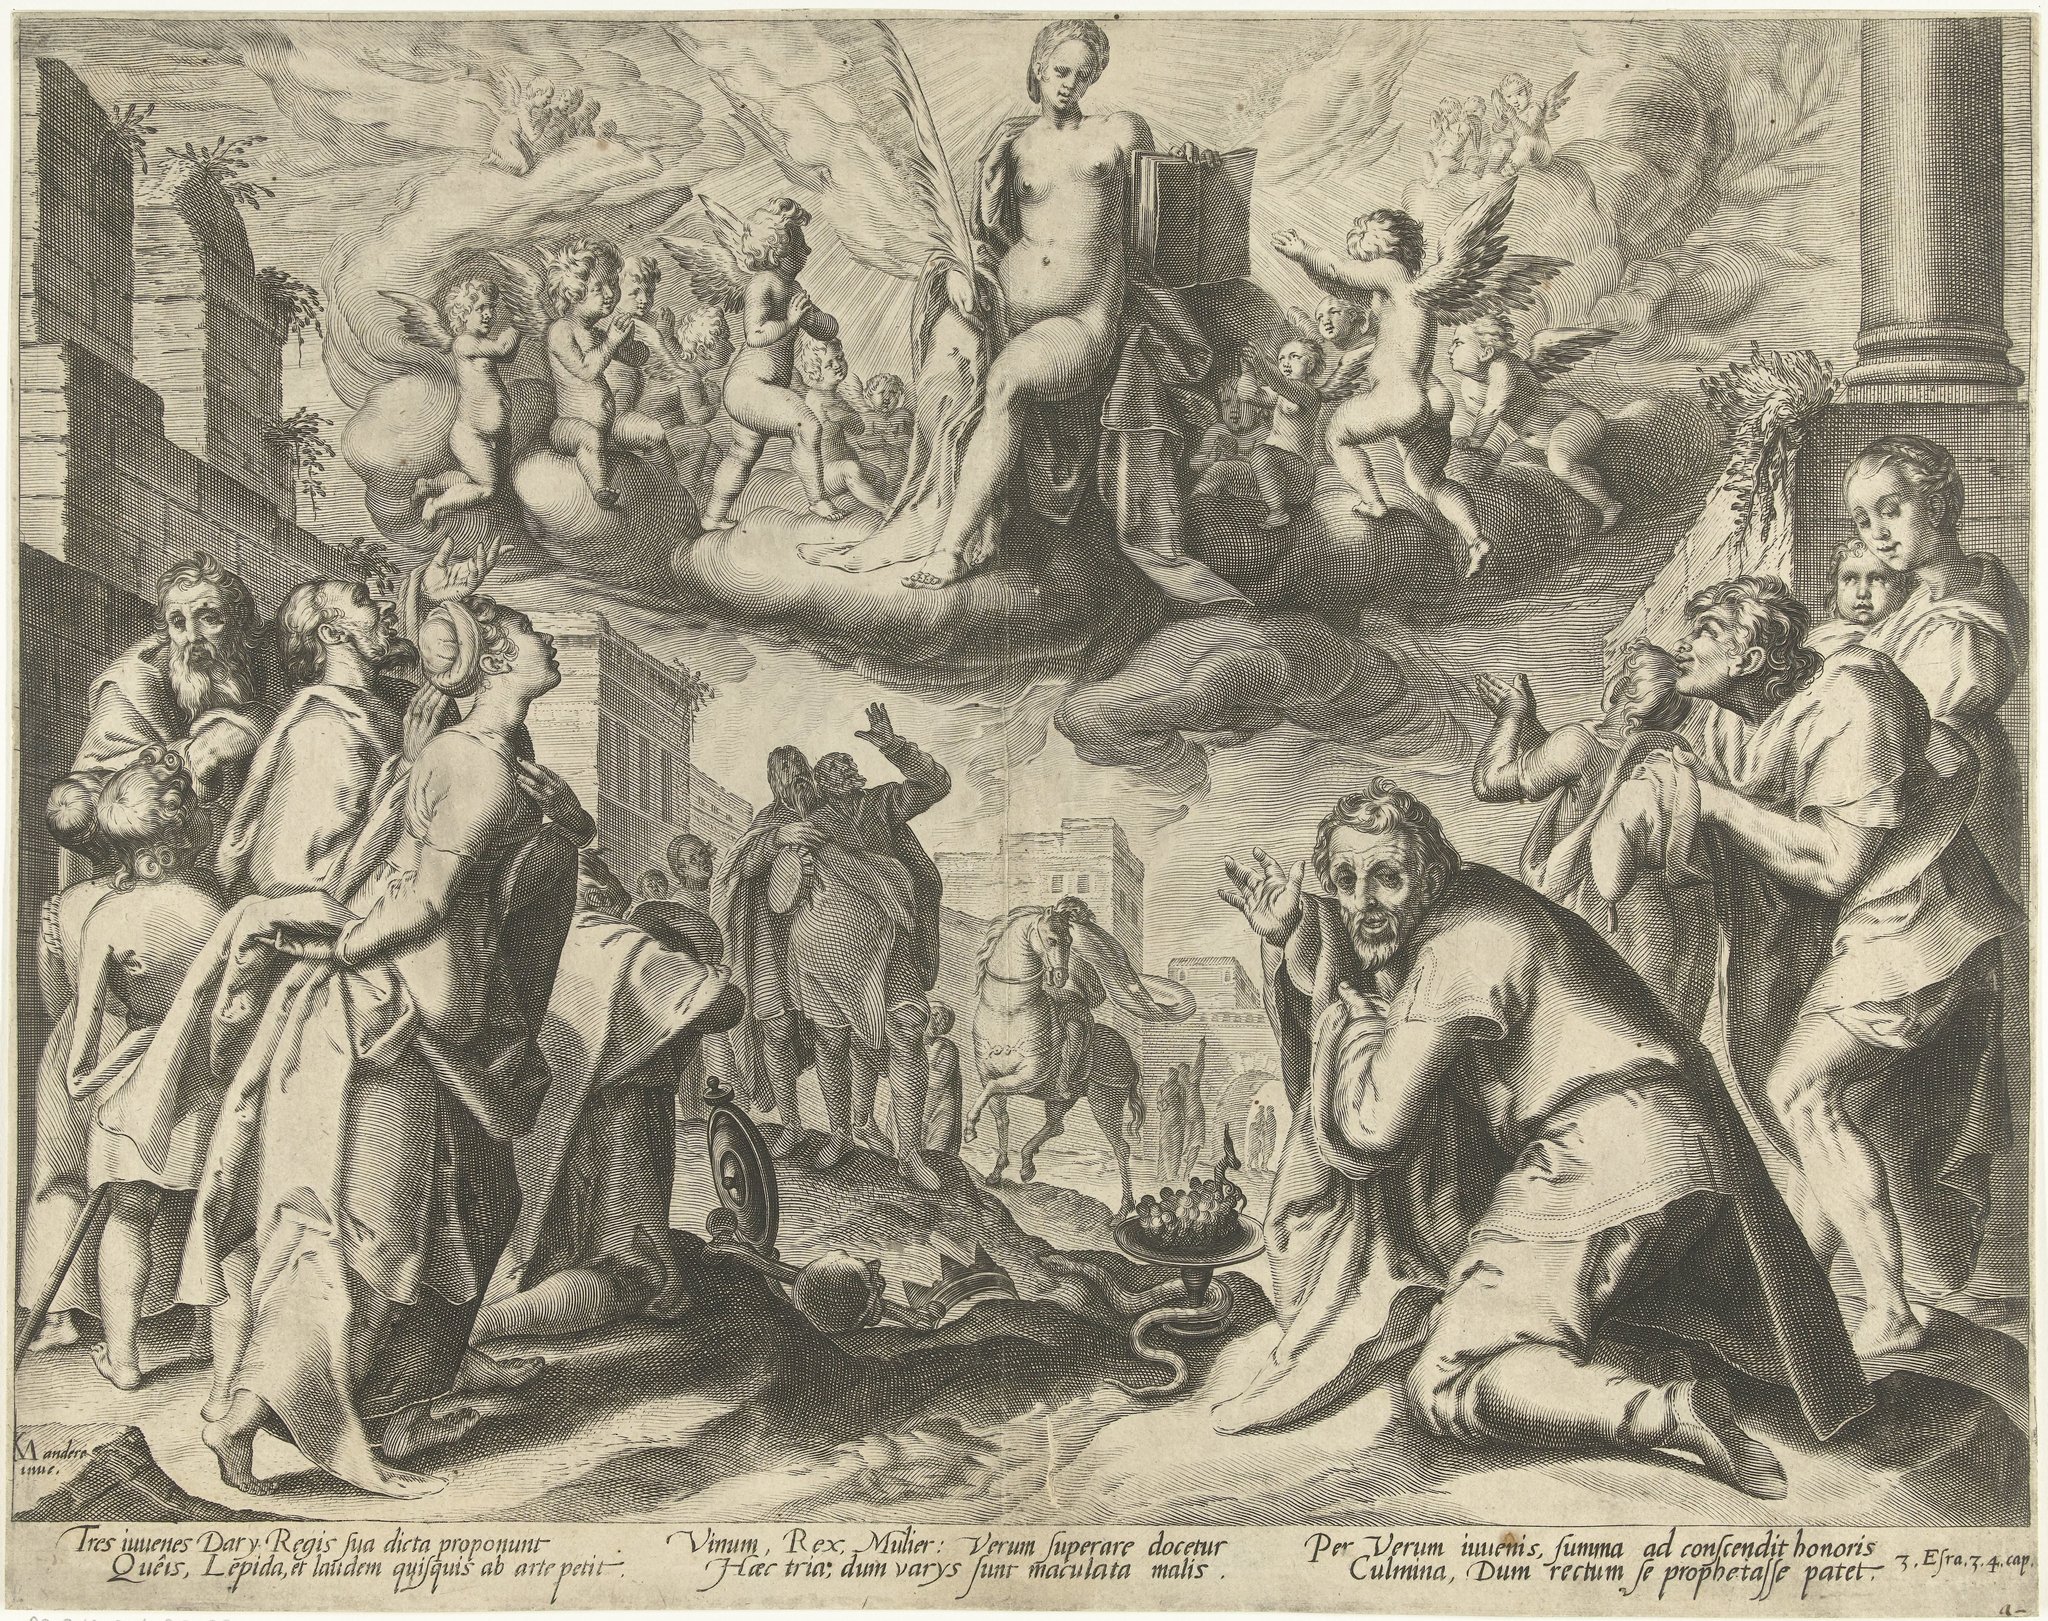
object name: print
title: Triomf van de waarheid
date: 1558-1606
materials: paper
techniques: engraving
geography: amsterdam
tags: the contest of the three guardsmen in king darius' bedchamber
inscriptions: collector's mark: Lugt 2228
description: Een straat in een stad. Mensen staan of knielen voor de vrouwelijke verschijning van De Waarheid, die boven hun hoofden zweeft. Ze draagt een palmtak in haar rechterhand en een boek in haar linkerhand. Een engelenkoor knielt rondom haar. In het midden van de prent liggen een beker met druiven (wijn), een koningskroon (de monarchie), een schedel (de dood en de erfzonde) en een spiegel (ijdelheid) op de grond. De prent beeldt een scène uit het apocriefe boek Esdras (hoofdstuk 3 en 4) uit. Drie dienaren van koning Darius van Perzië argumenteren of dat respectievelijk wijn, de koning en de vrouw het sterkste is ter wereld. Zerubbabel, de laatste dienaar (waarschijnlijk de man rechts van het midden op de prent), wint de discussie met het antwoord dat vrouwen het sterkste zijn ter wereld, maar dat de waarheid alles overwint. Als beloning mag Zerubbabel met het herstel van de tempel in Jeruzalem beginnen. De prent heeft een Latijns onderschrift met een citaat uit het apocriefe boek Esdras (3-4).